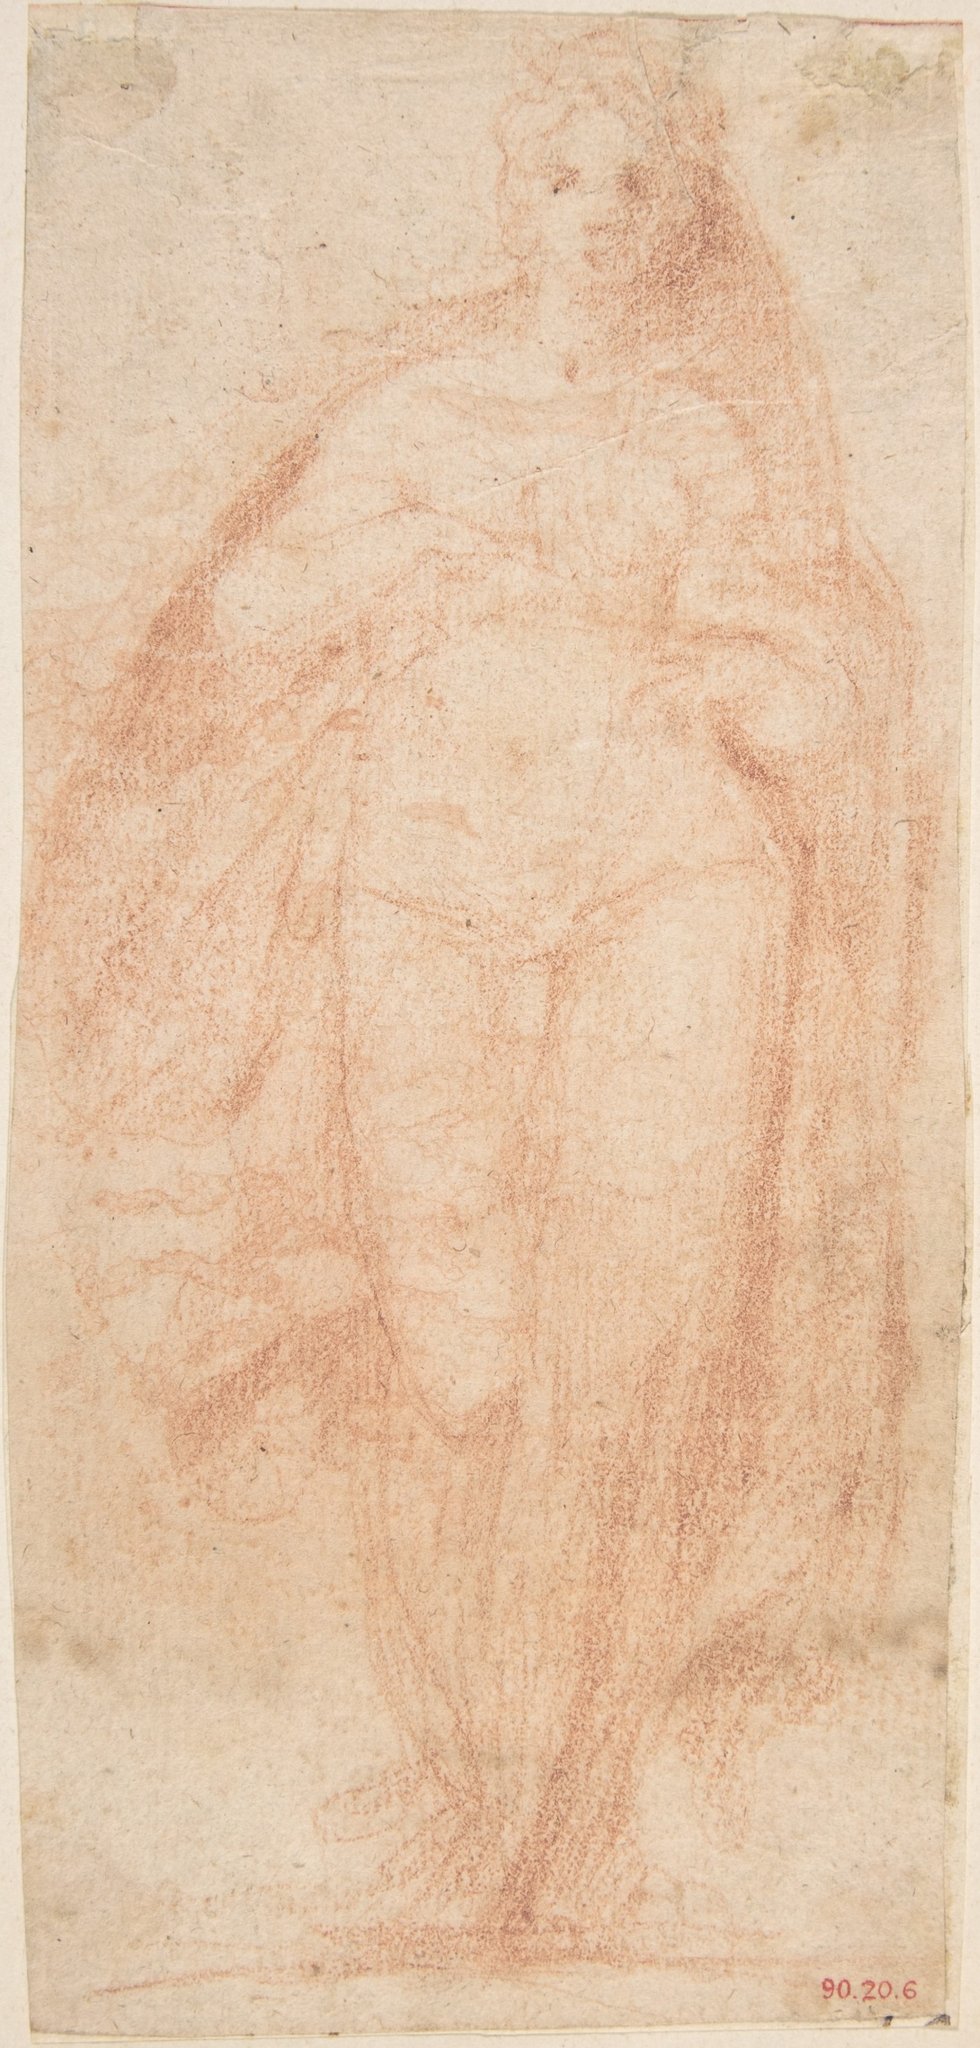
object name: drawing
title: Advancing Figure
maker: cavaliere d'arpino (giuseppe cesari)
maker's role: artist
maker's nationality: italian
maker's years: 1568-1640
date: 1568-1640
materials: chalk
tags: women